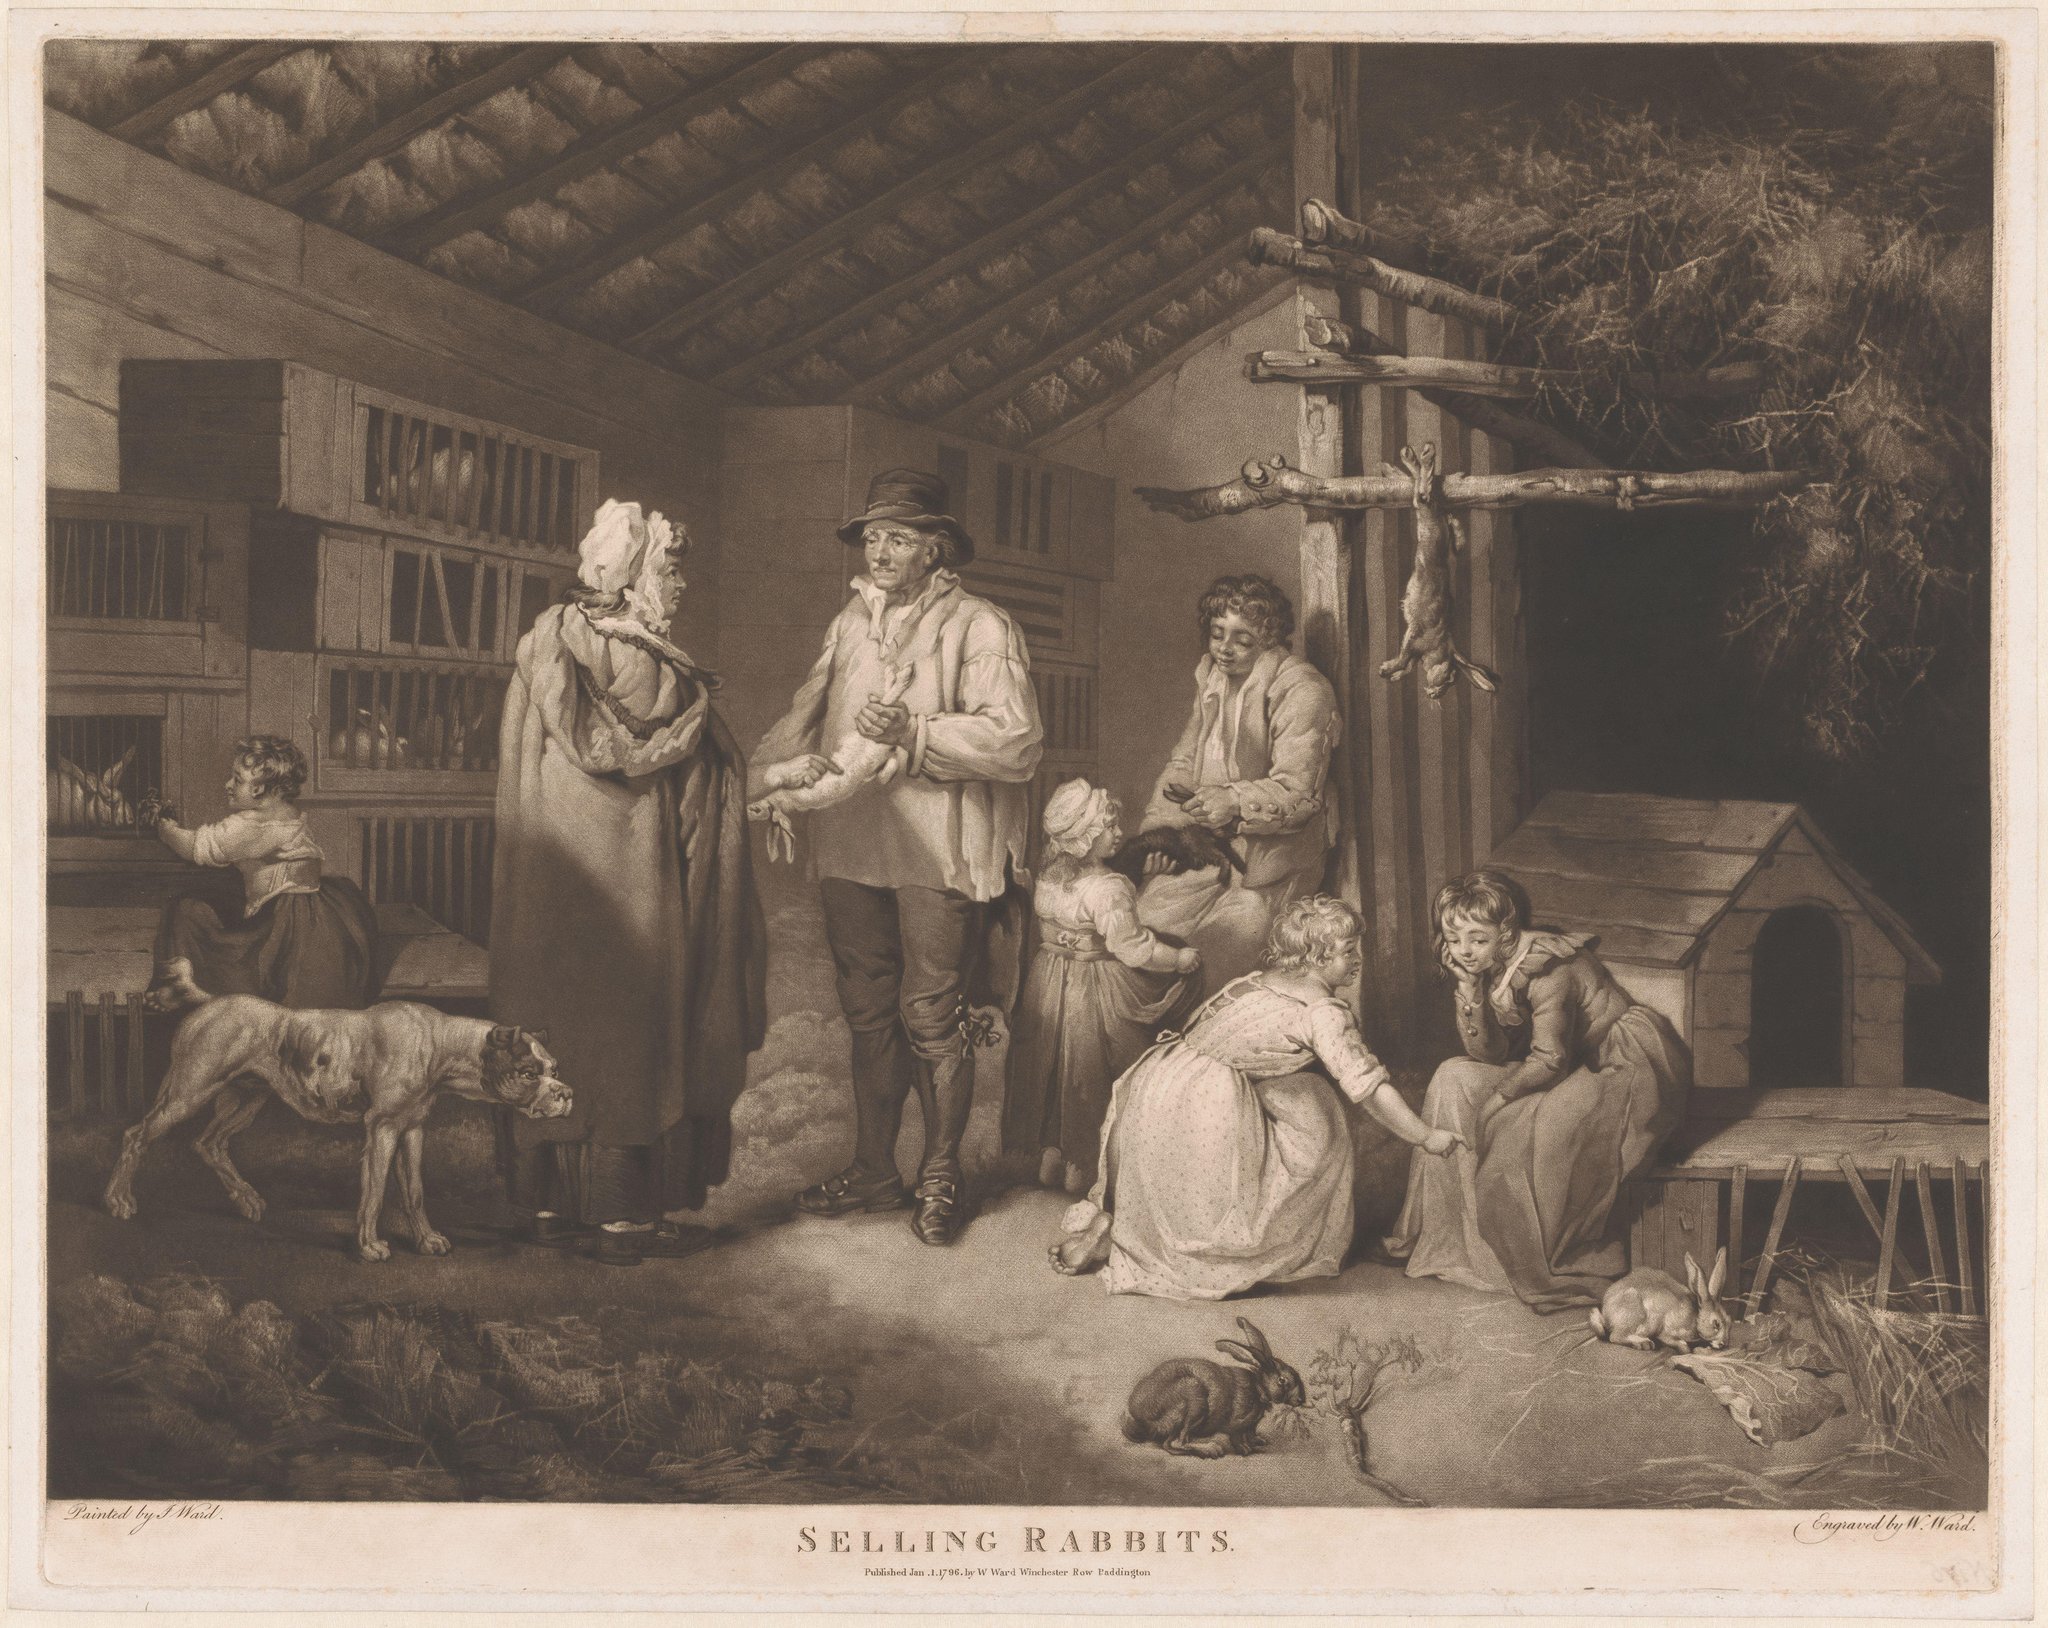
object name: print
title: Selling Rabbits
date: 1796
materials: paper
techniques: engraving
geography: london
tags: rodents: rabbit, merchant, salesman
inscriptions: number: ‘N. 176’